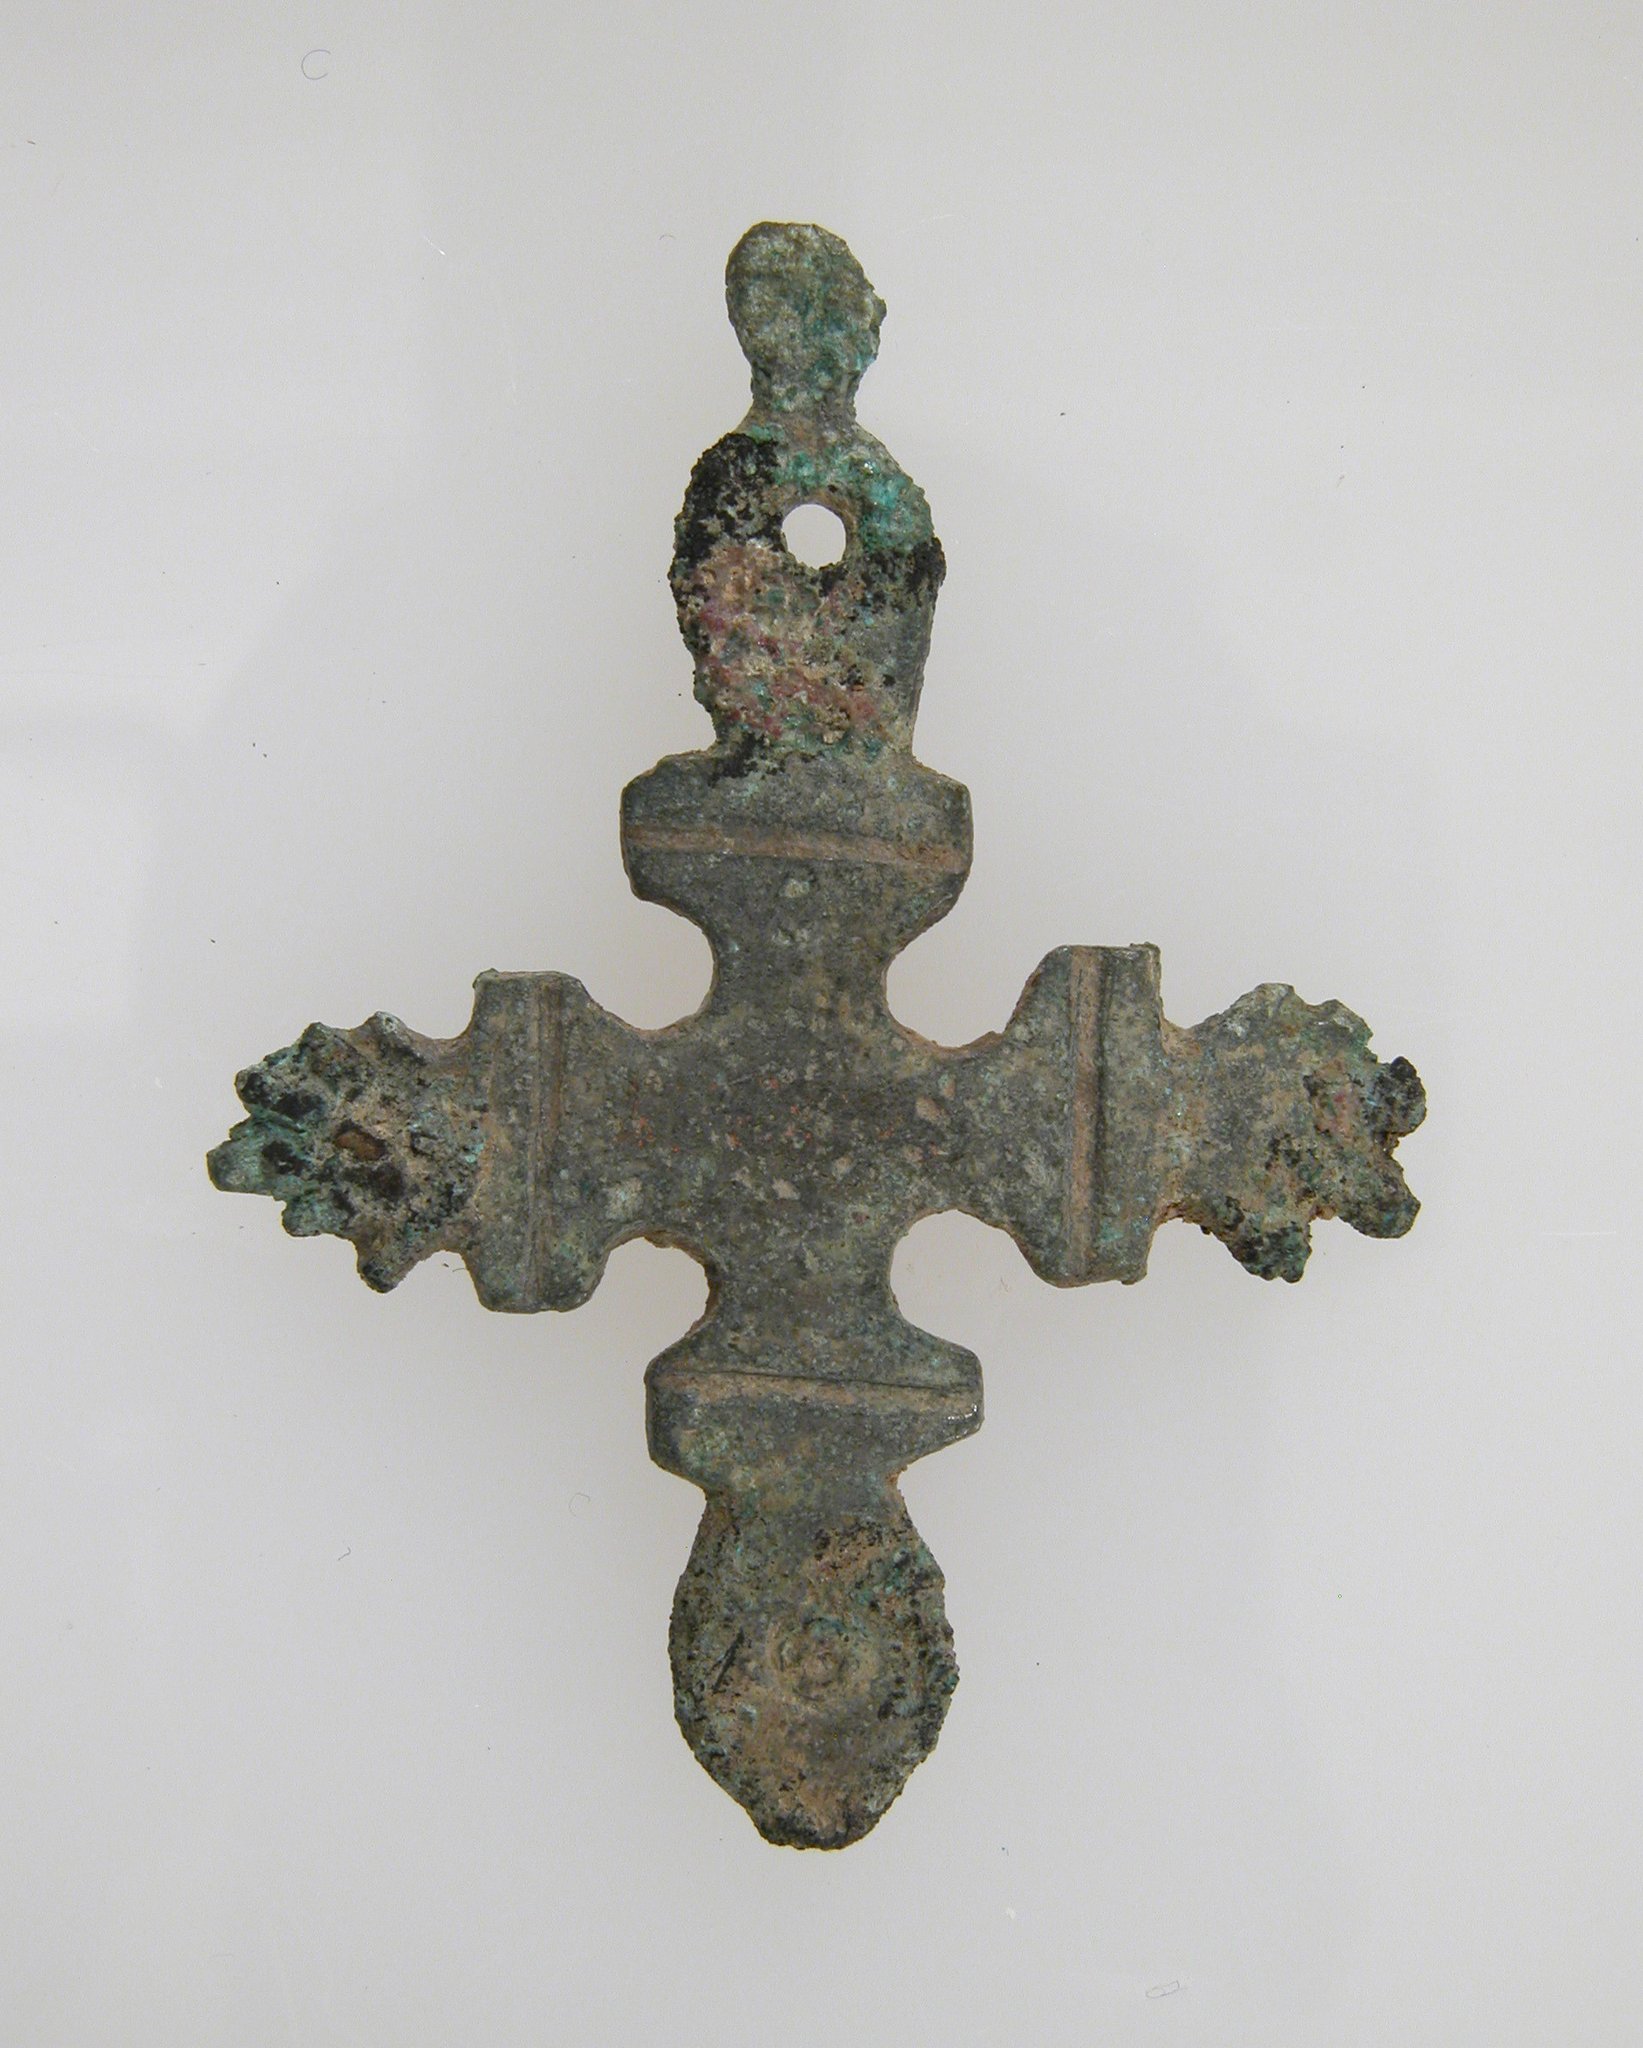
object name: cross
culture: frankish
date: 500-600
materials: copper alloy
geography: germany